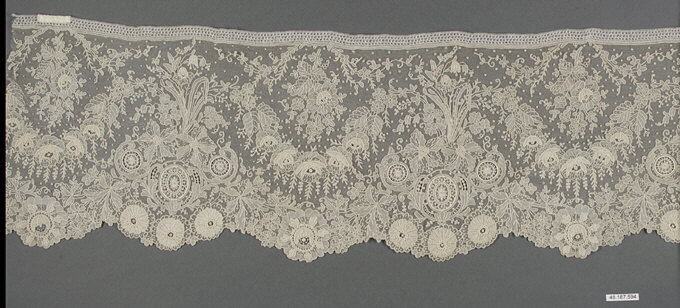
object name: border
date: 1851-1900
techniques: lace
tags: flowers